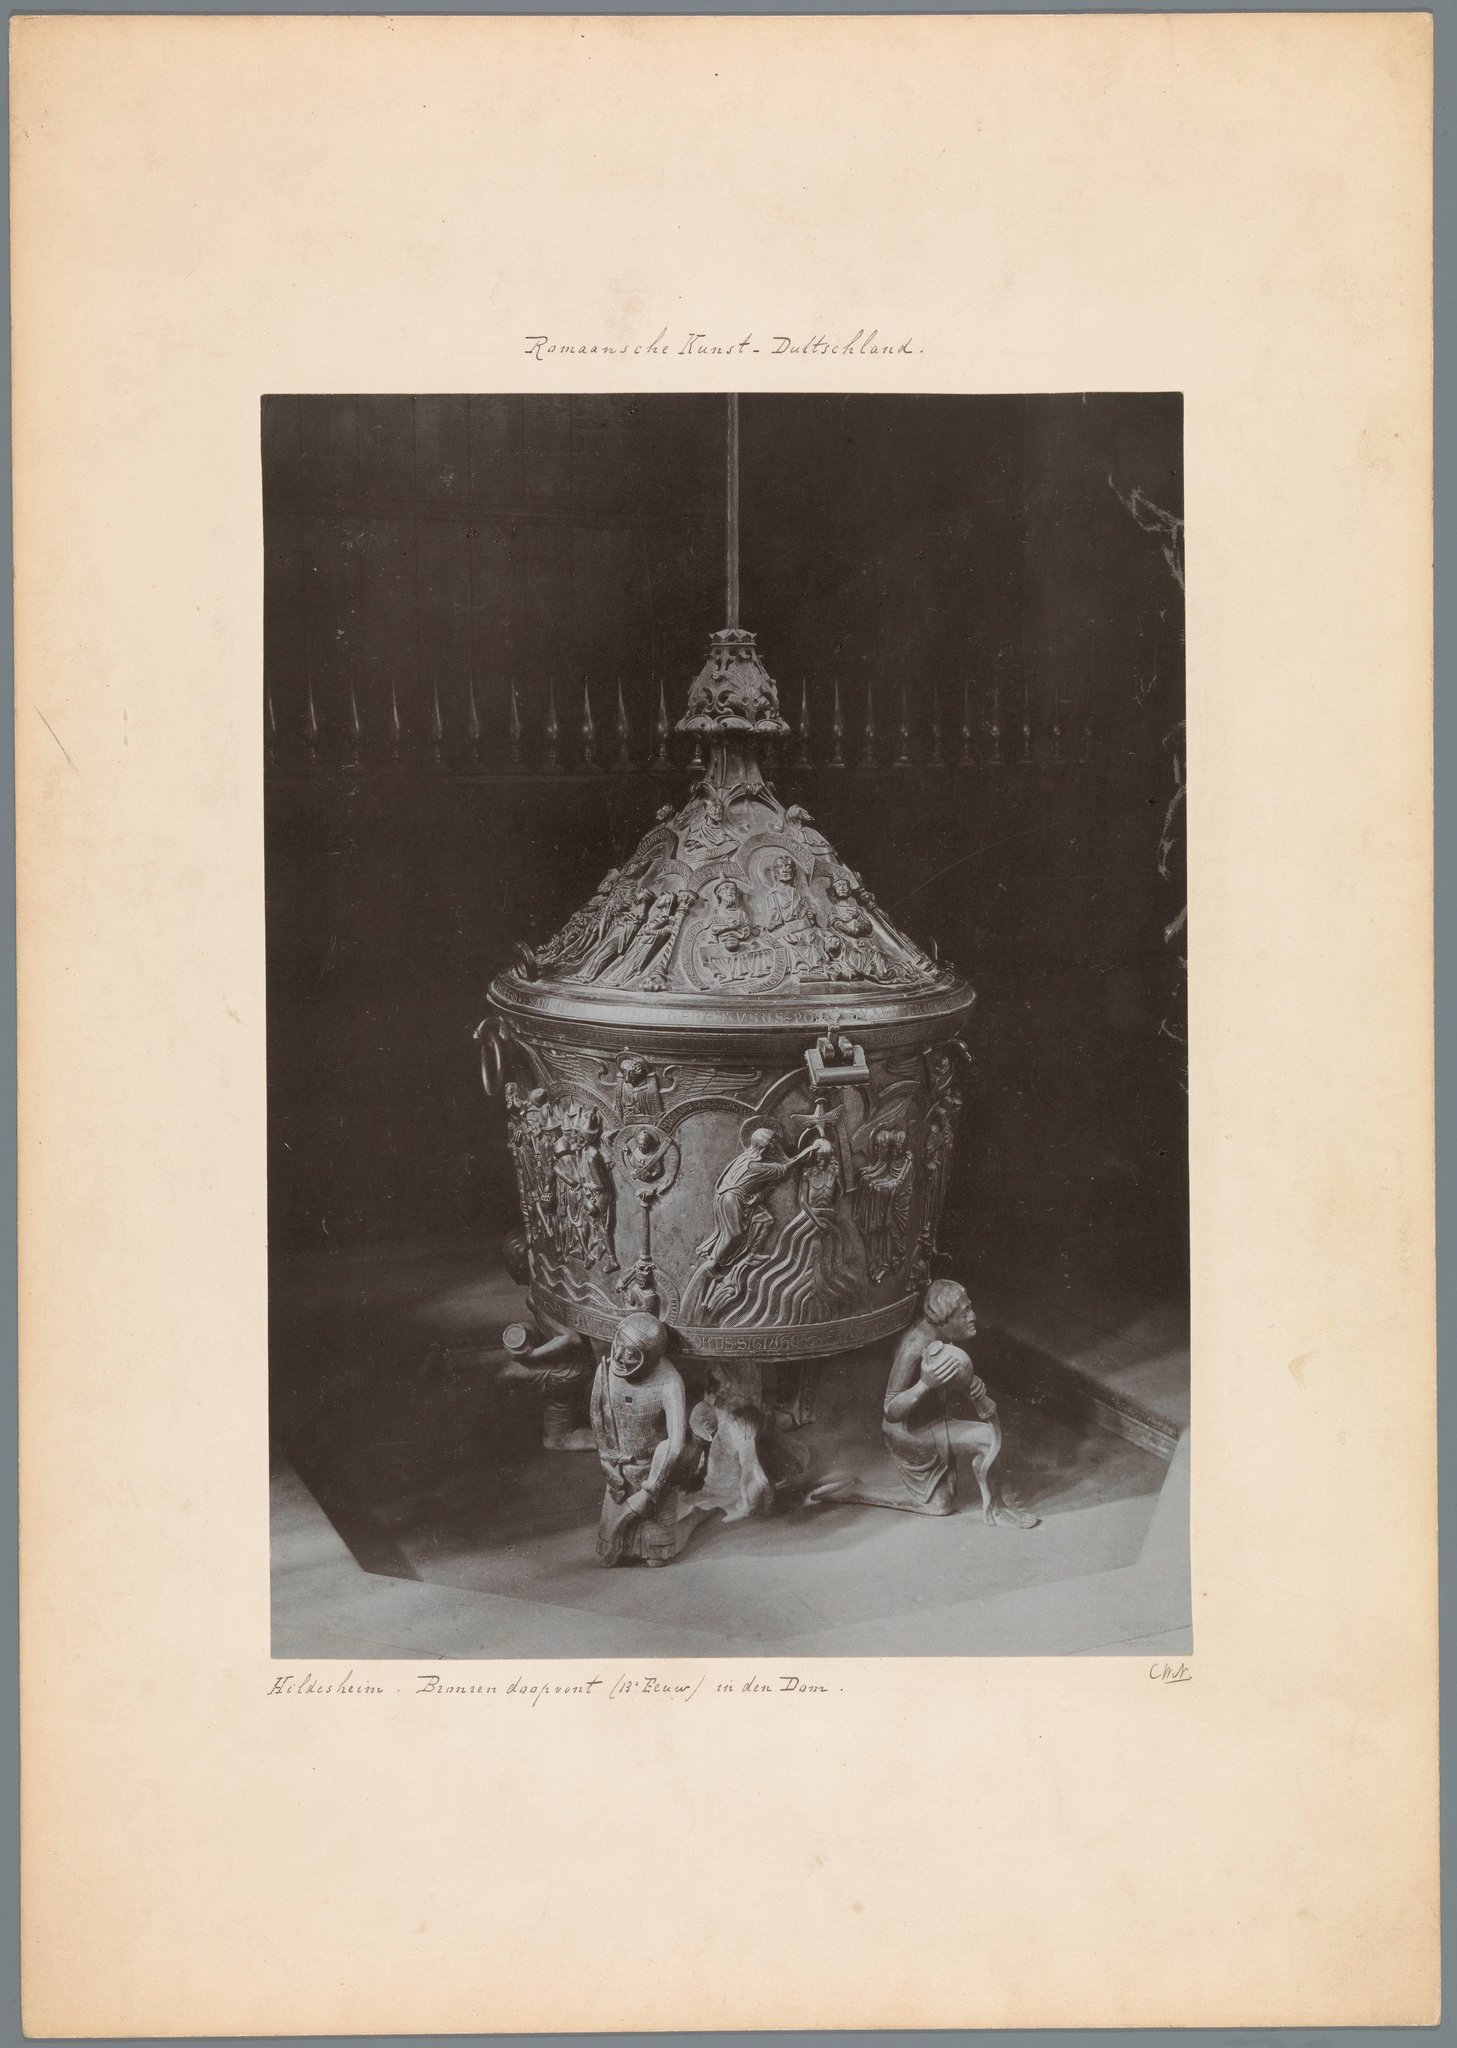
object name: photograph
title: Bronzen doopvont in de Dom van Hildesheim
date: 1897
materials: cardboard, paper, ink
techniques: photograph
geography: hildesheim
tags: baptism of christ in the river jordan: john the baptist pouring out water on christ's head: the holy ghost descends, interior of church, baptismal font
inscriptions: collector's mark: ‘KUNSTNIJVERHEIDSCHOOL QUELLINUS AMSTERDAM FRANS HALSSTRAAT 14.’, name: ‘STENGEL & CO 1897 DRESDEN’, inscription: ‘Romaansche Kunst - Duitschland. Hildesheim . Bronzen doopvont (13e Eeuw) in den Dom.’, inscription: ‘CWN.’, collector's mark: ‘INSTITUUT VOOR KUNST- NIJVERHEIDSONDERWIJS GABRIËL METSUSTRAAT No. 16. AMSTERDAM’